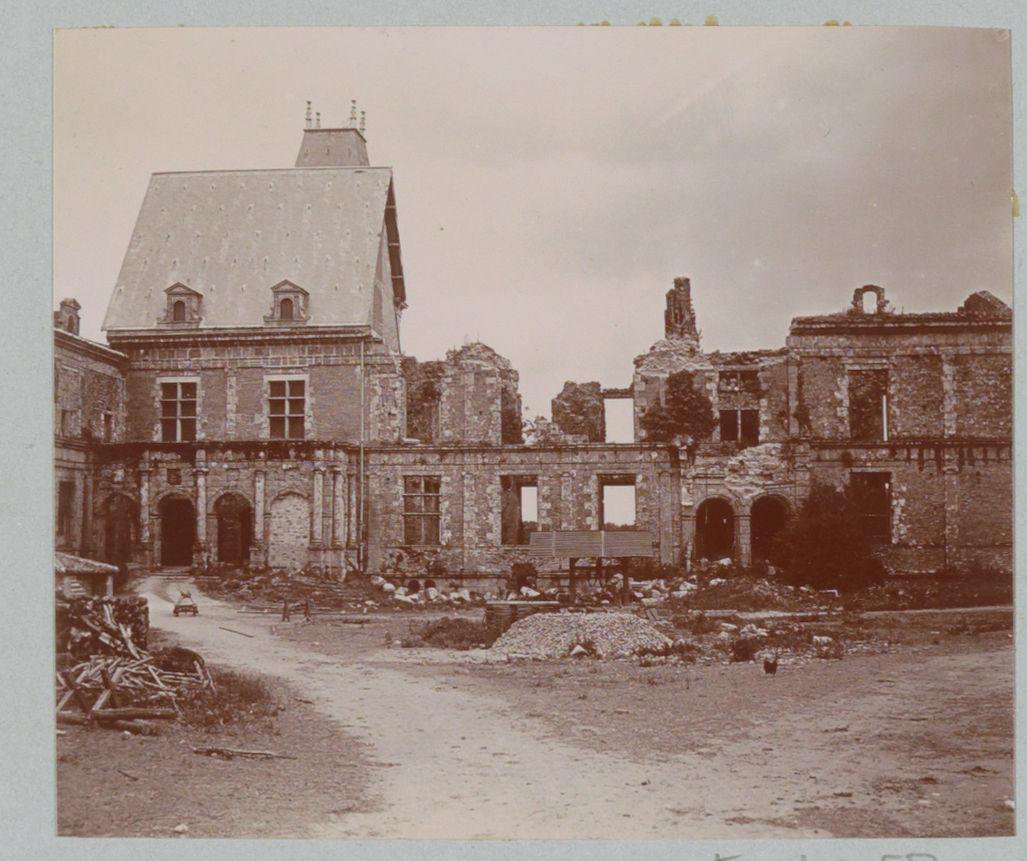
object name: photograph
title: Deels vervallen huis, vermoedelijk aan de Loire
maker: Anonymous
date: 1905-1910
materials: paper, photographic support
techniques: gelatin silver print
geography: france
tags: ruin of a dwelling, house, castle, etc., france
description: Onderdeel van Fotoalbum van een Franse amateurfotograaf met bezienswaardigheden in Frankrijk, Zwitserland en Italië.